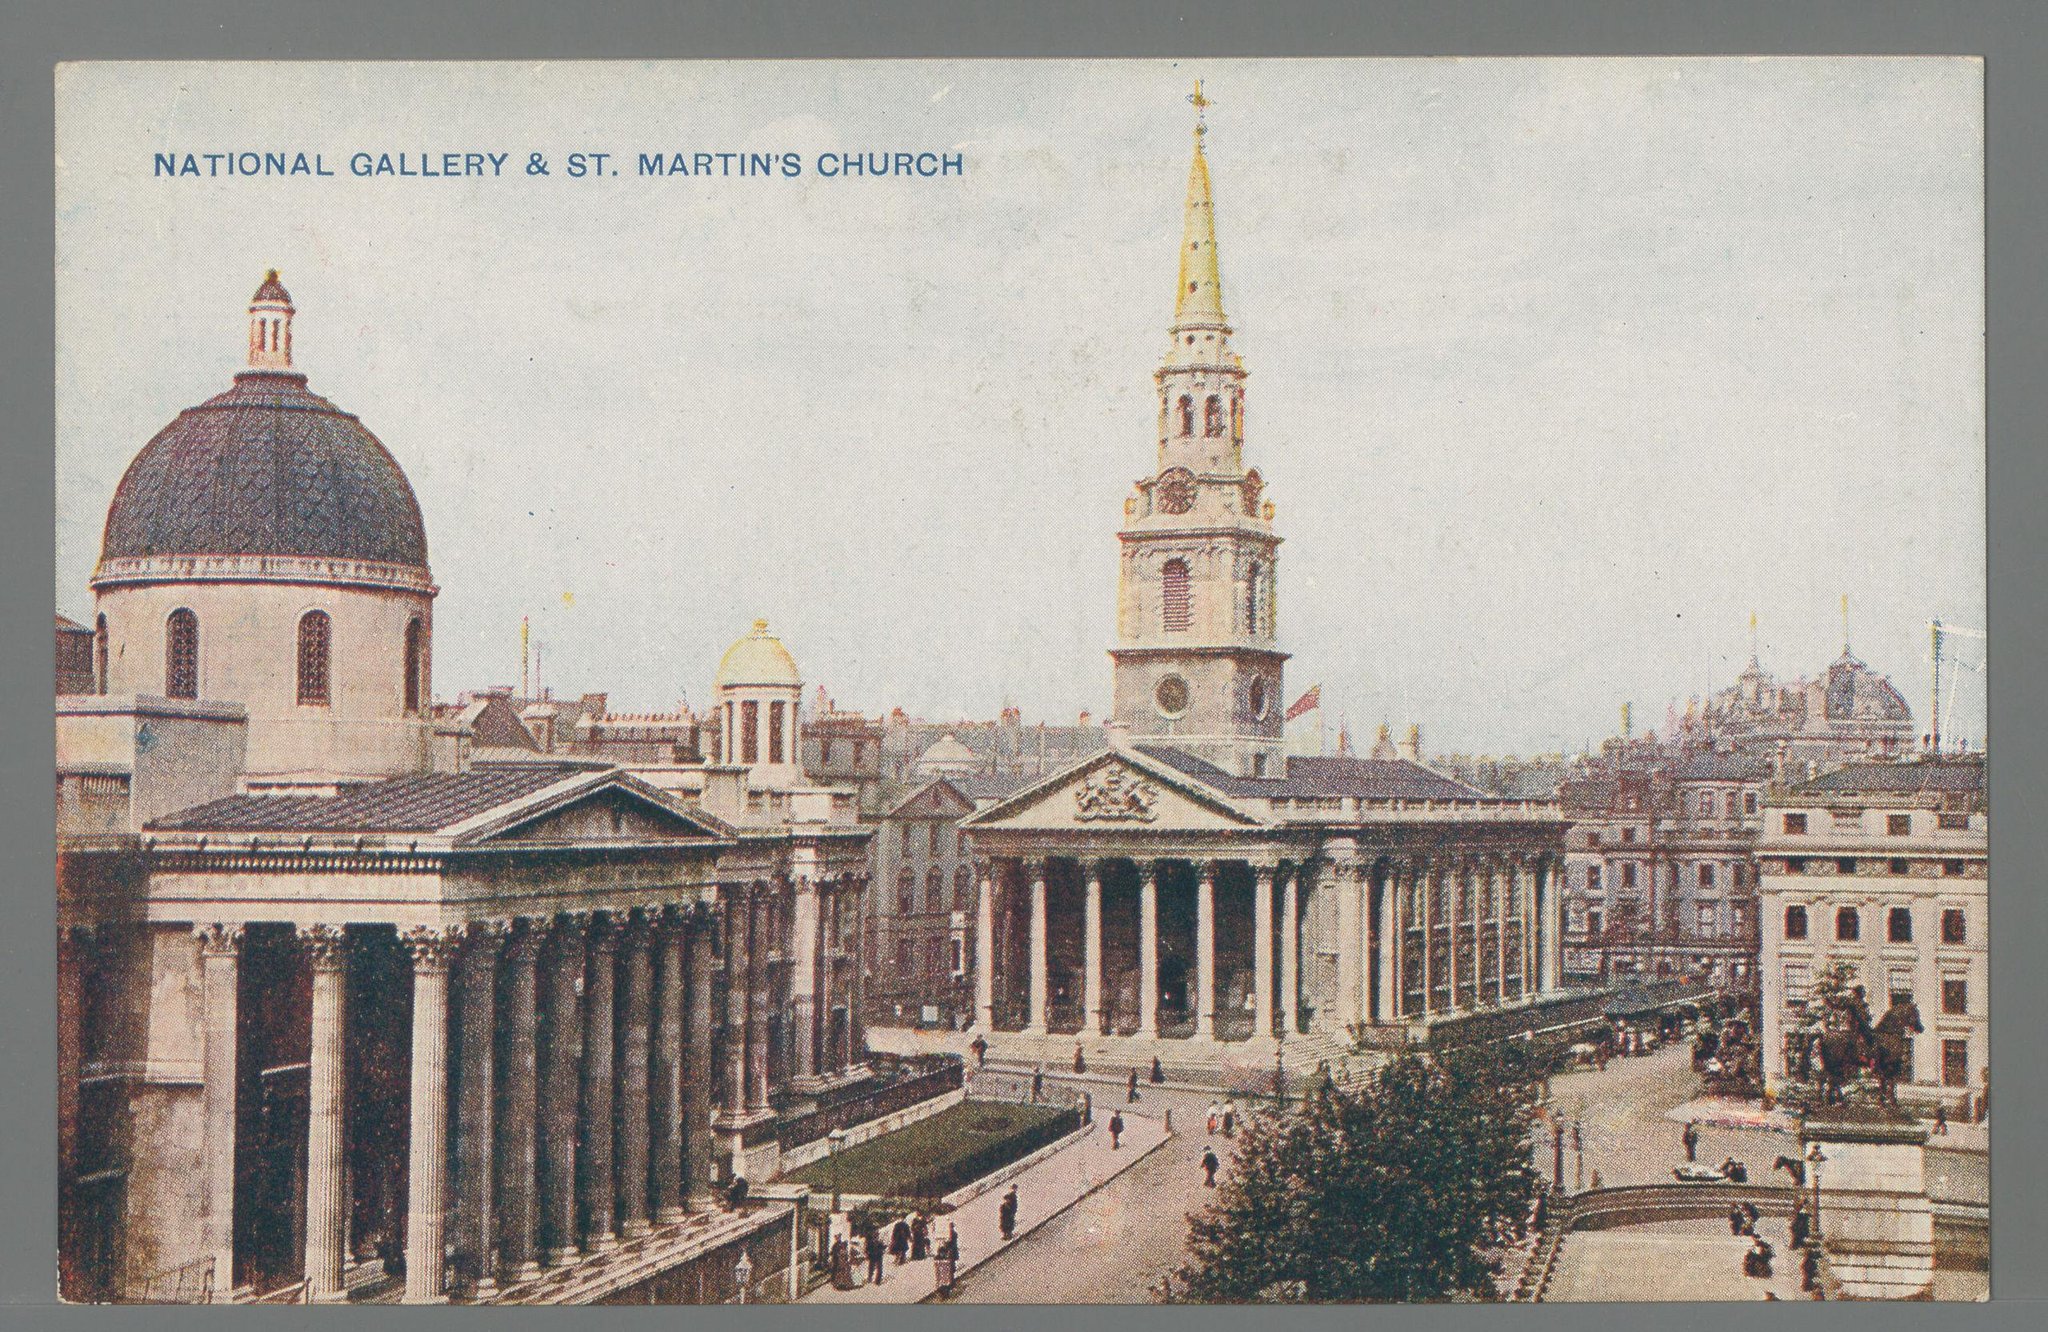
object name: photomechanical print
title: Exclusive Celesque series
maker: Anonymous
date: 1902-1930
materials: cardboard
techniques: color autotype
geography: london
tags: church (exterior), permanent exhibition, museum